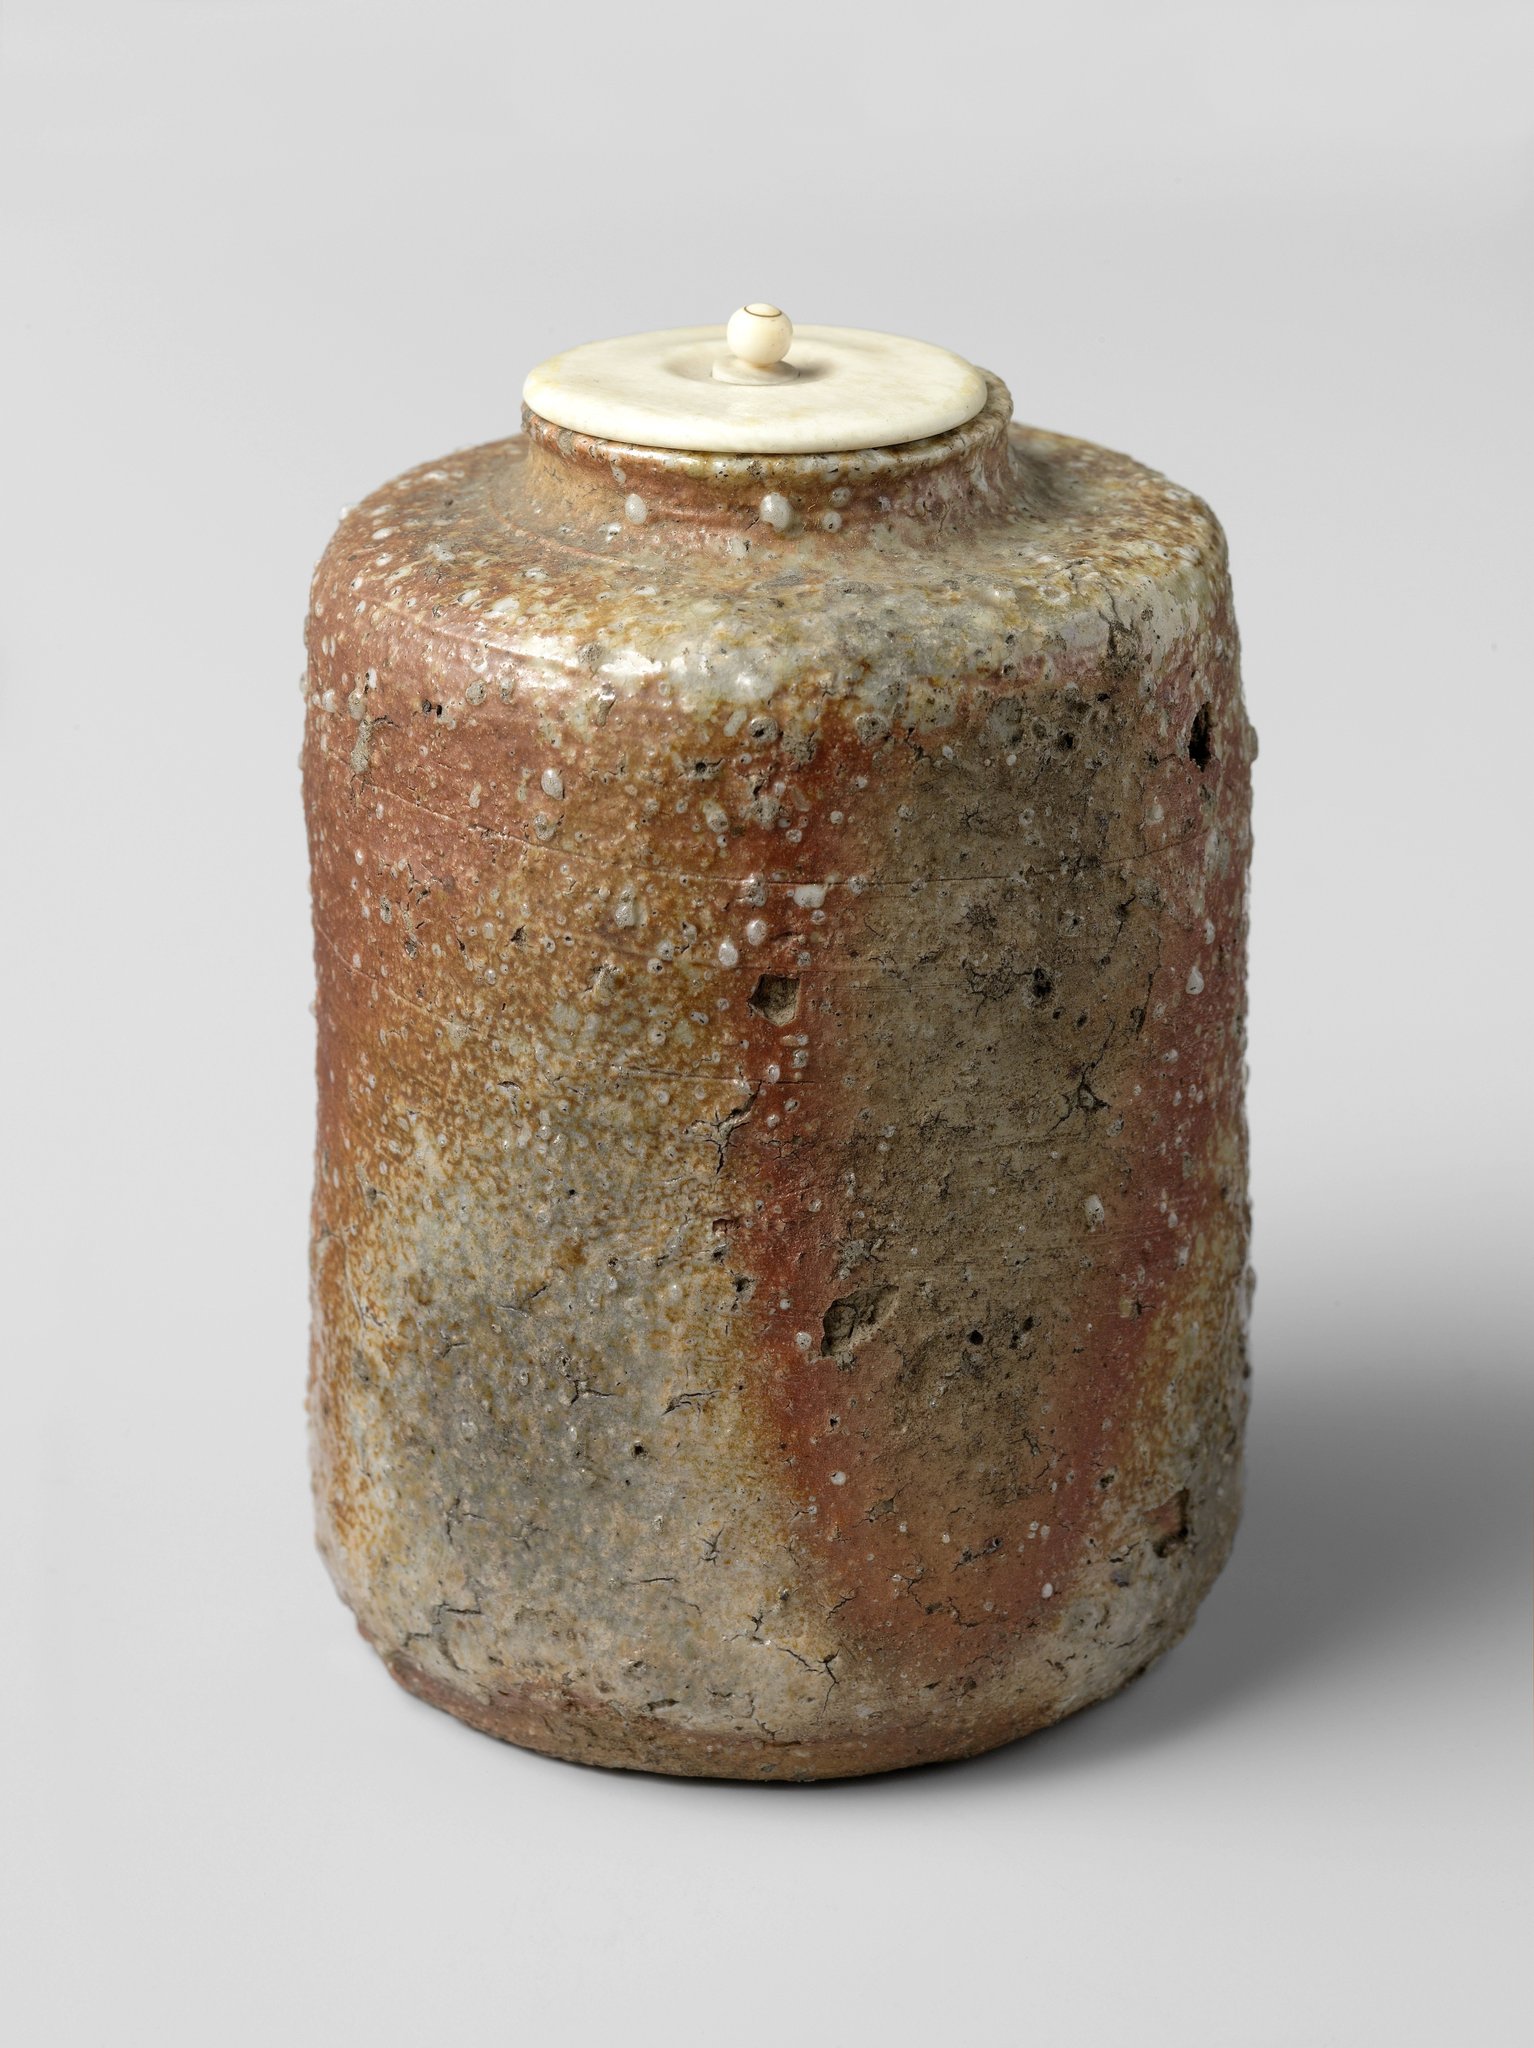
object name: chaire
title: Tea caddy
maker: Anonymous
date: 1600-1799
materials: glaze, ivory, stoneware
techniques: firing, turning, vitrification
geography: shigaraki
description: Cilindrische stoftheebus of chaire van steengoed met een ivoren deksel, gedeeltelijk bedekt met een crèmekleurig glazuur. De bus heeft een oranjebruine kleur met op de schouder en gedeeltes van de wand een crèmekleurig glazuur. Shigaraki.